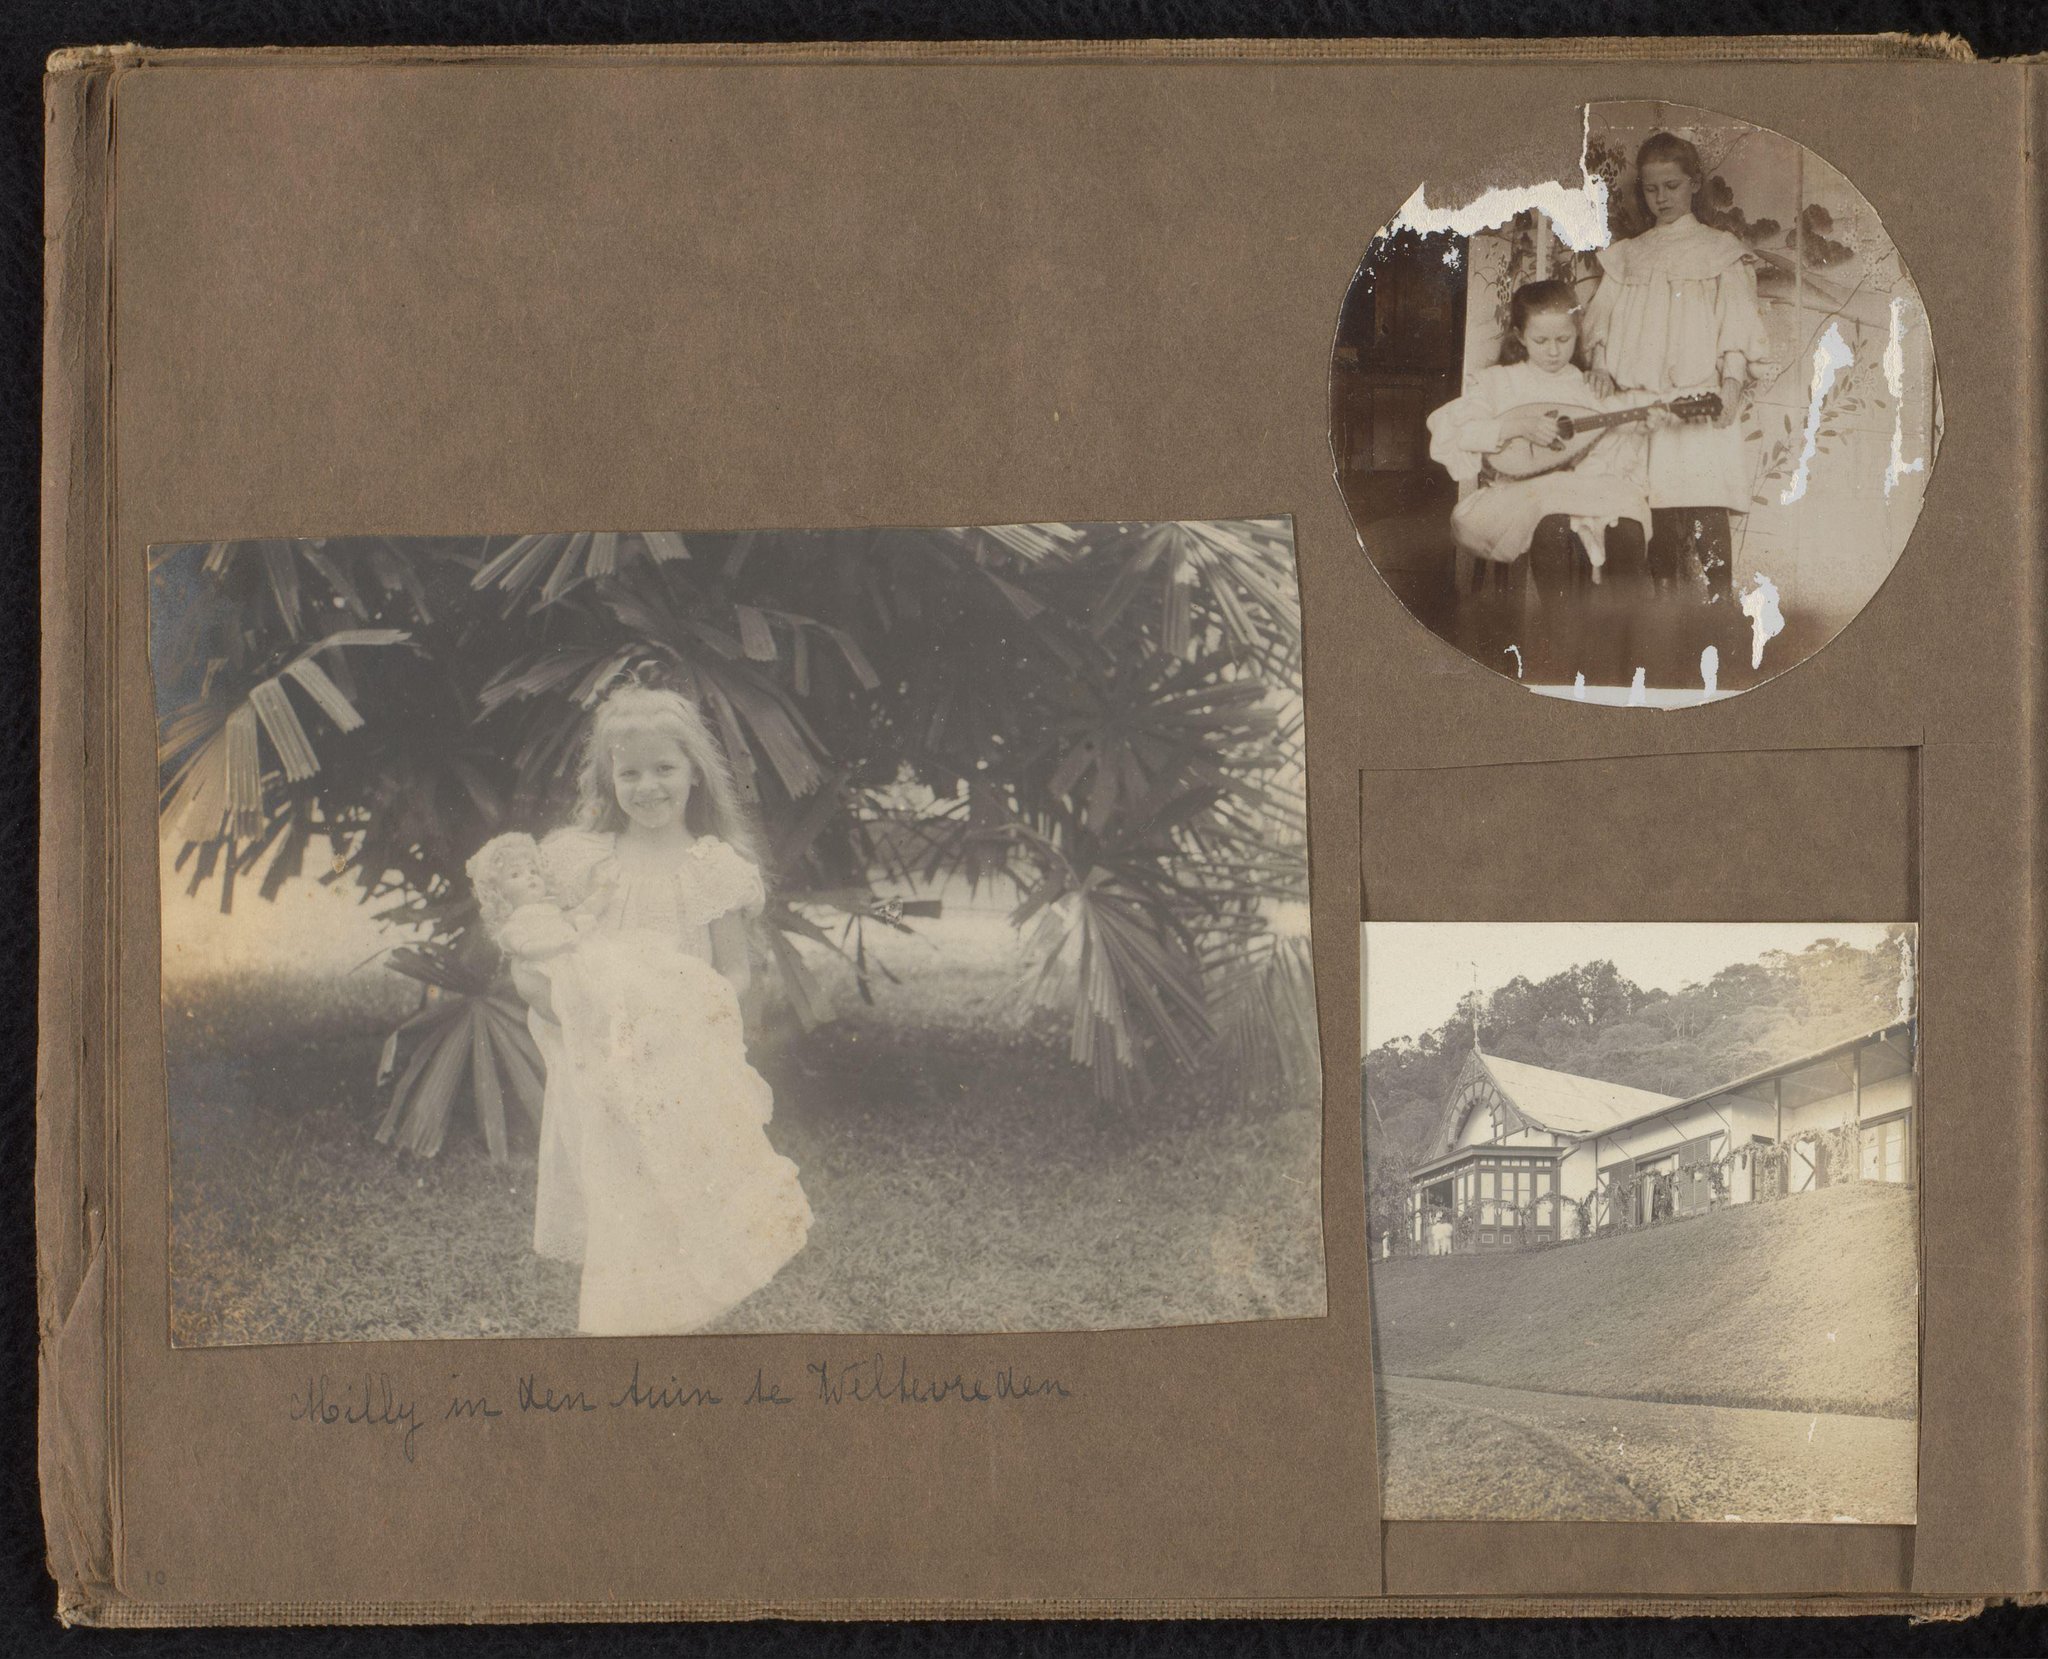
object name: album leaf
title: Twee foto's van meisjes, onder andere aangeduid als Milly, Weltevreden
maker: carolina frederika onnen (lien/loen)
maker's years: 1896-1983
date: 1908-1910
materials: paper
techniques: gelatin silver print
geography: batavia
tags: historical persons not known by name - bb - woman, girl (child between toddler and youth), batavia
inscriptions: inscription: ‘Milly in den tuin te Weltevreden’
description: Rechtsonder is een stuk uit de pagina geknipt.